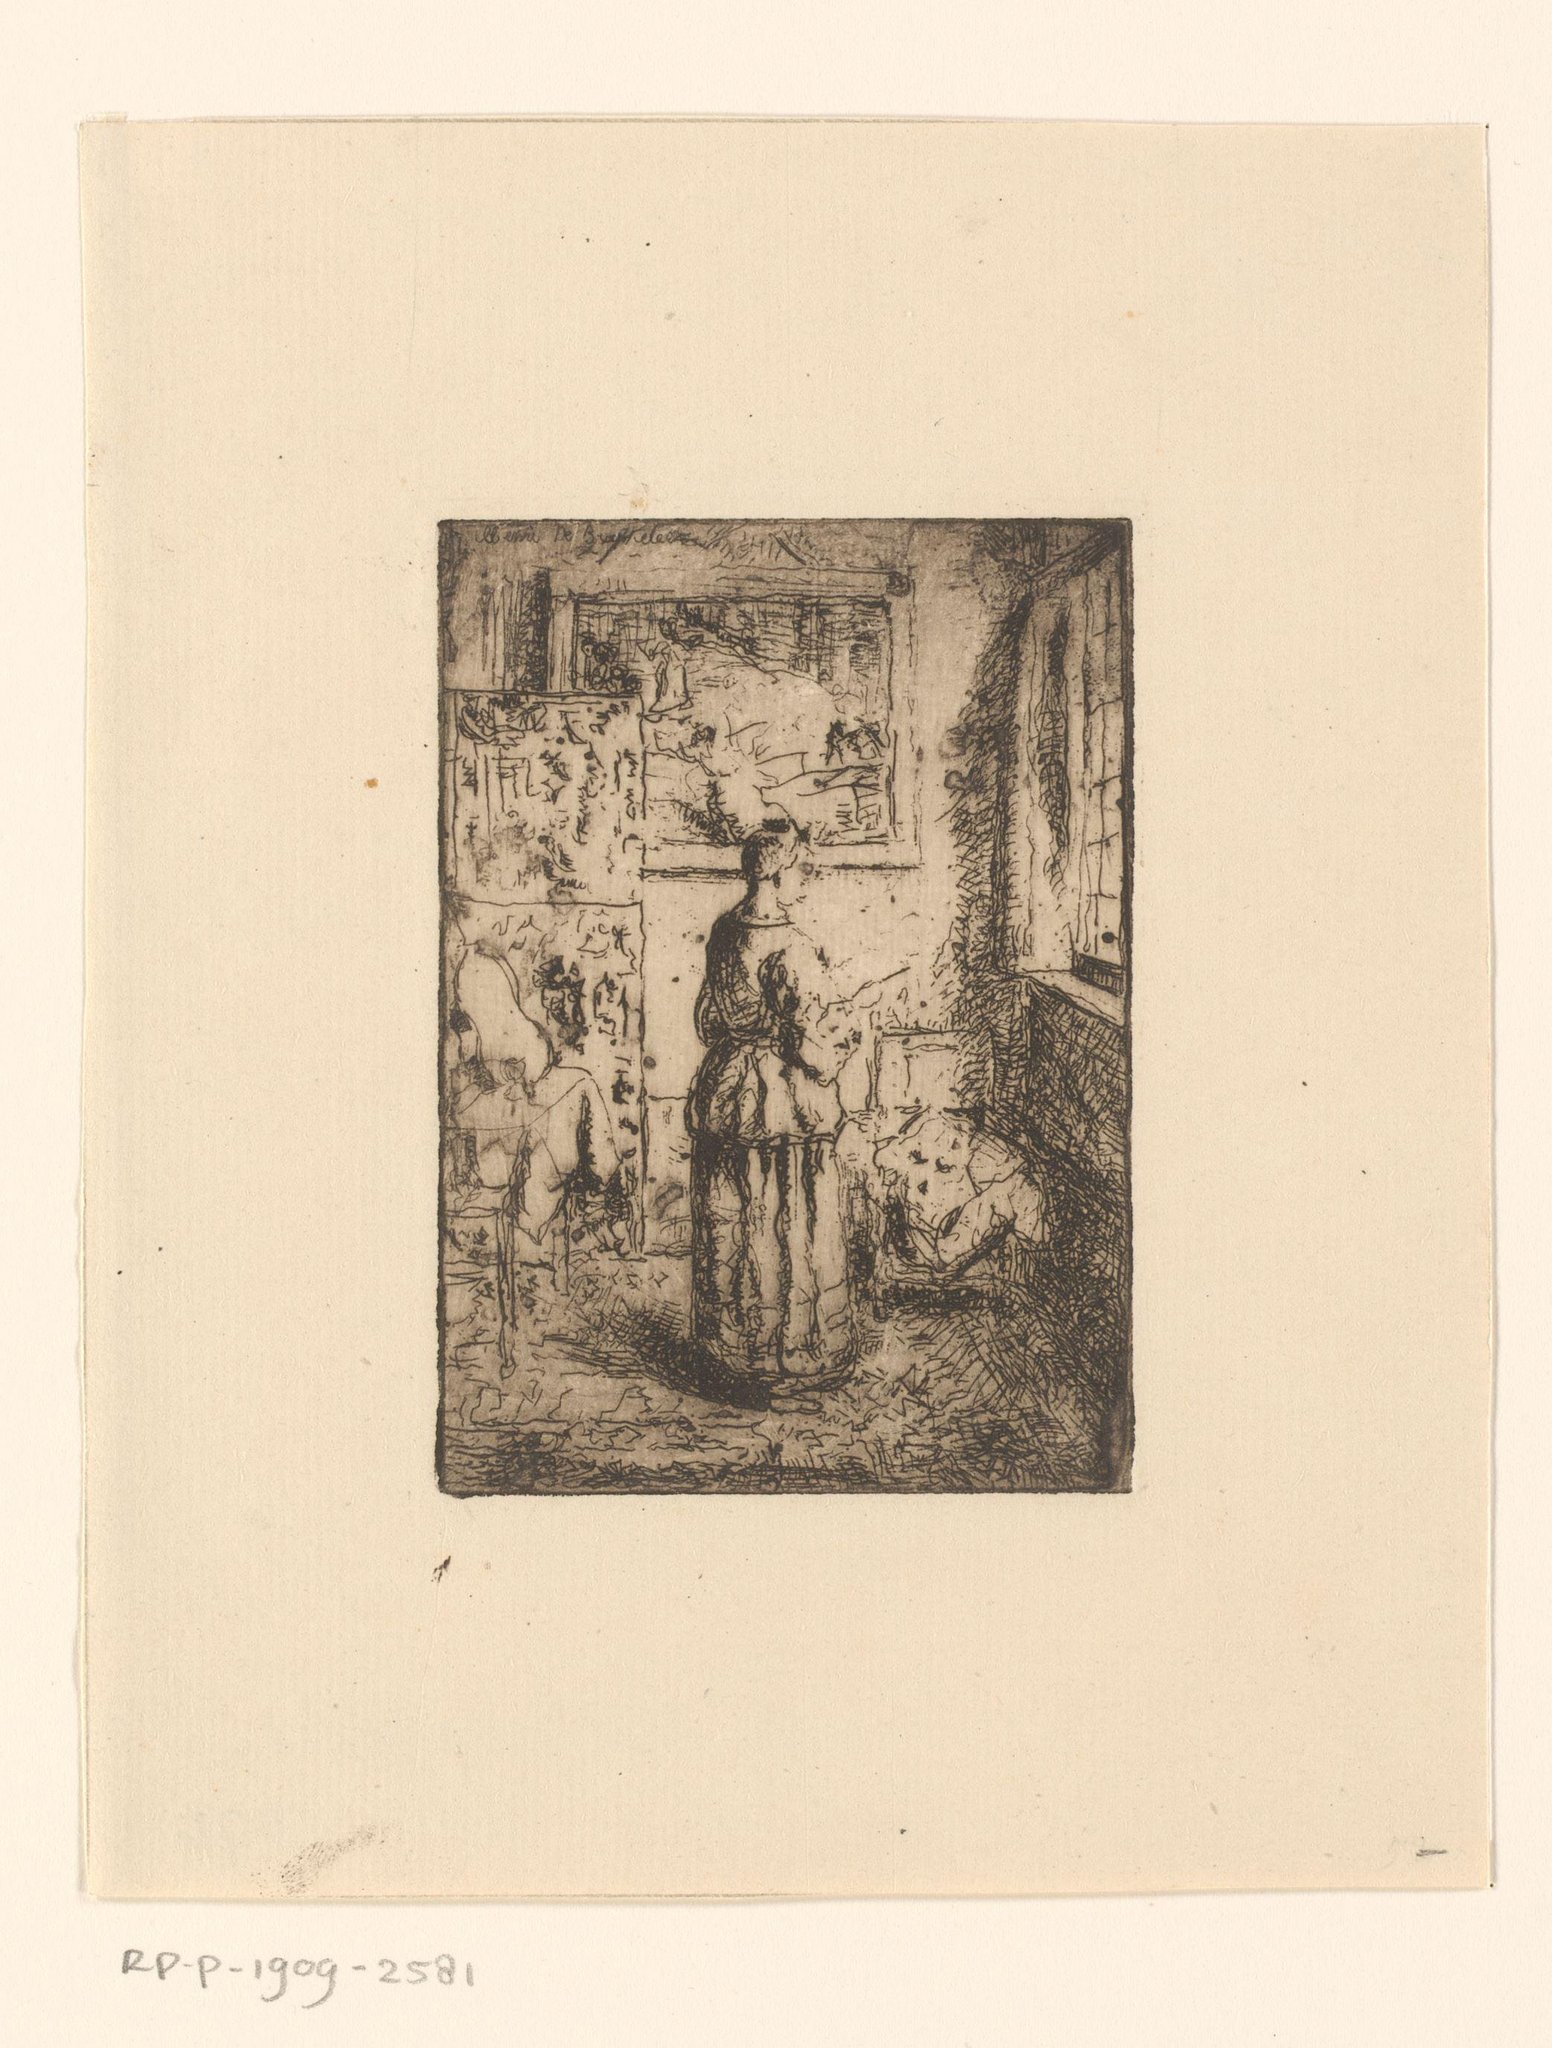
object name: print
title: Interieur met een jonge vrouw die een brief leest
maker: henri de braekeleer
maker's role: draughtsman, print maker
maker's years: 1840-1888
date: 1870-1875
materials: paper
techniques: etching, intaglio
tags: adolescent, young woman, maiden, letter, envelope, interior ~ representation of a building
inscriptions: collector's mark: Lugt 2228